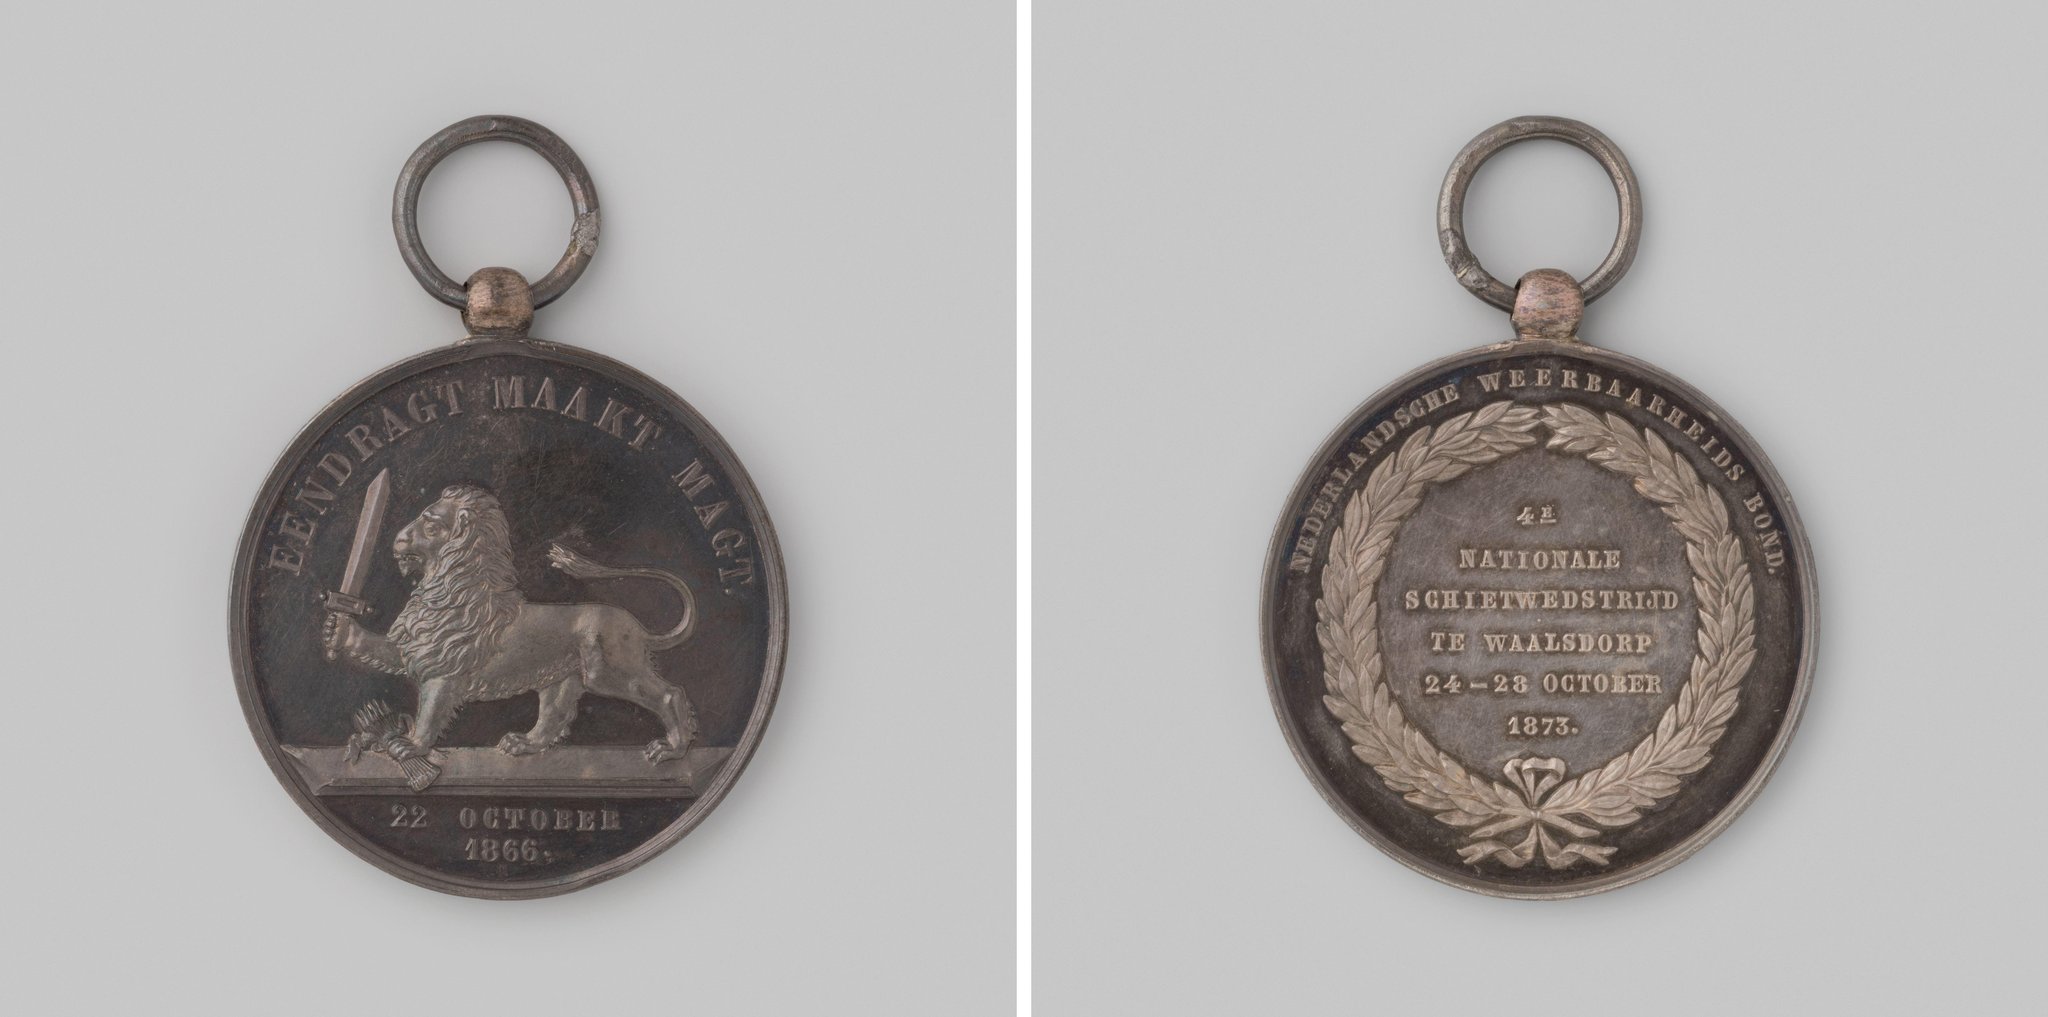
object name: draagpenning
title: Prijspenning van de Nederlandscshe Weerbaarheidsbond bij 4e Nationale Schietwedstrijd te Waalsdorp 1873, behaald door de schutterij van Amsterdam, eerste prijs voor Individueel-vuur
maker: Anonymous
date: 1873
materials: silver